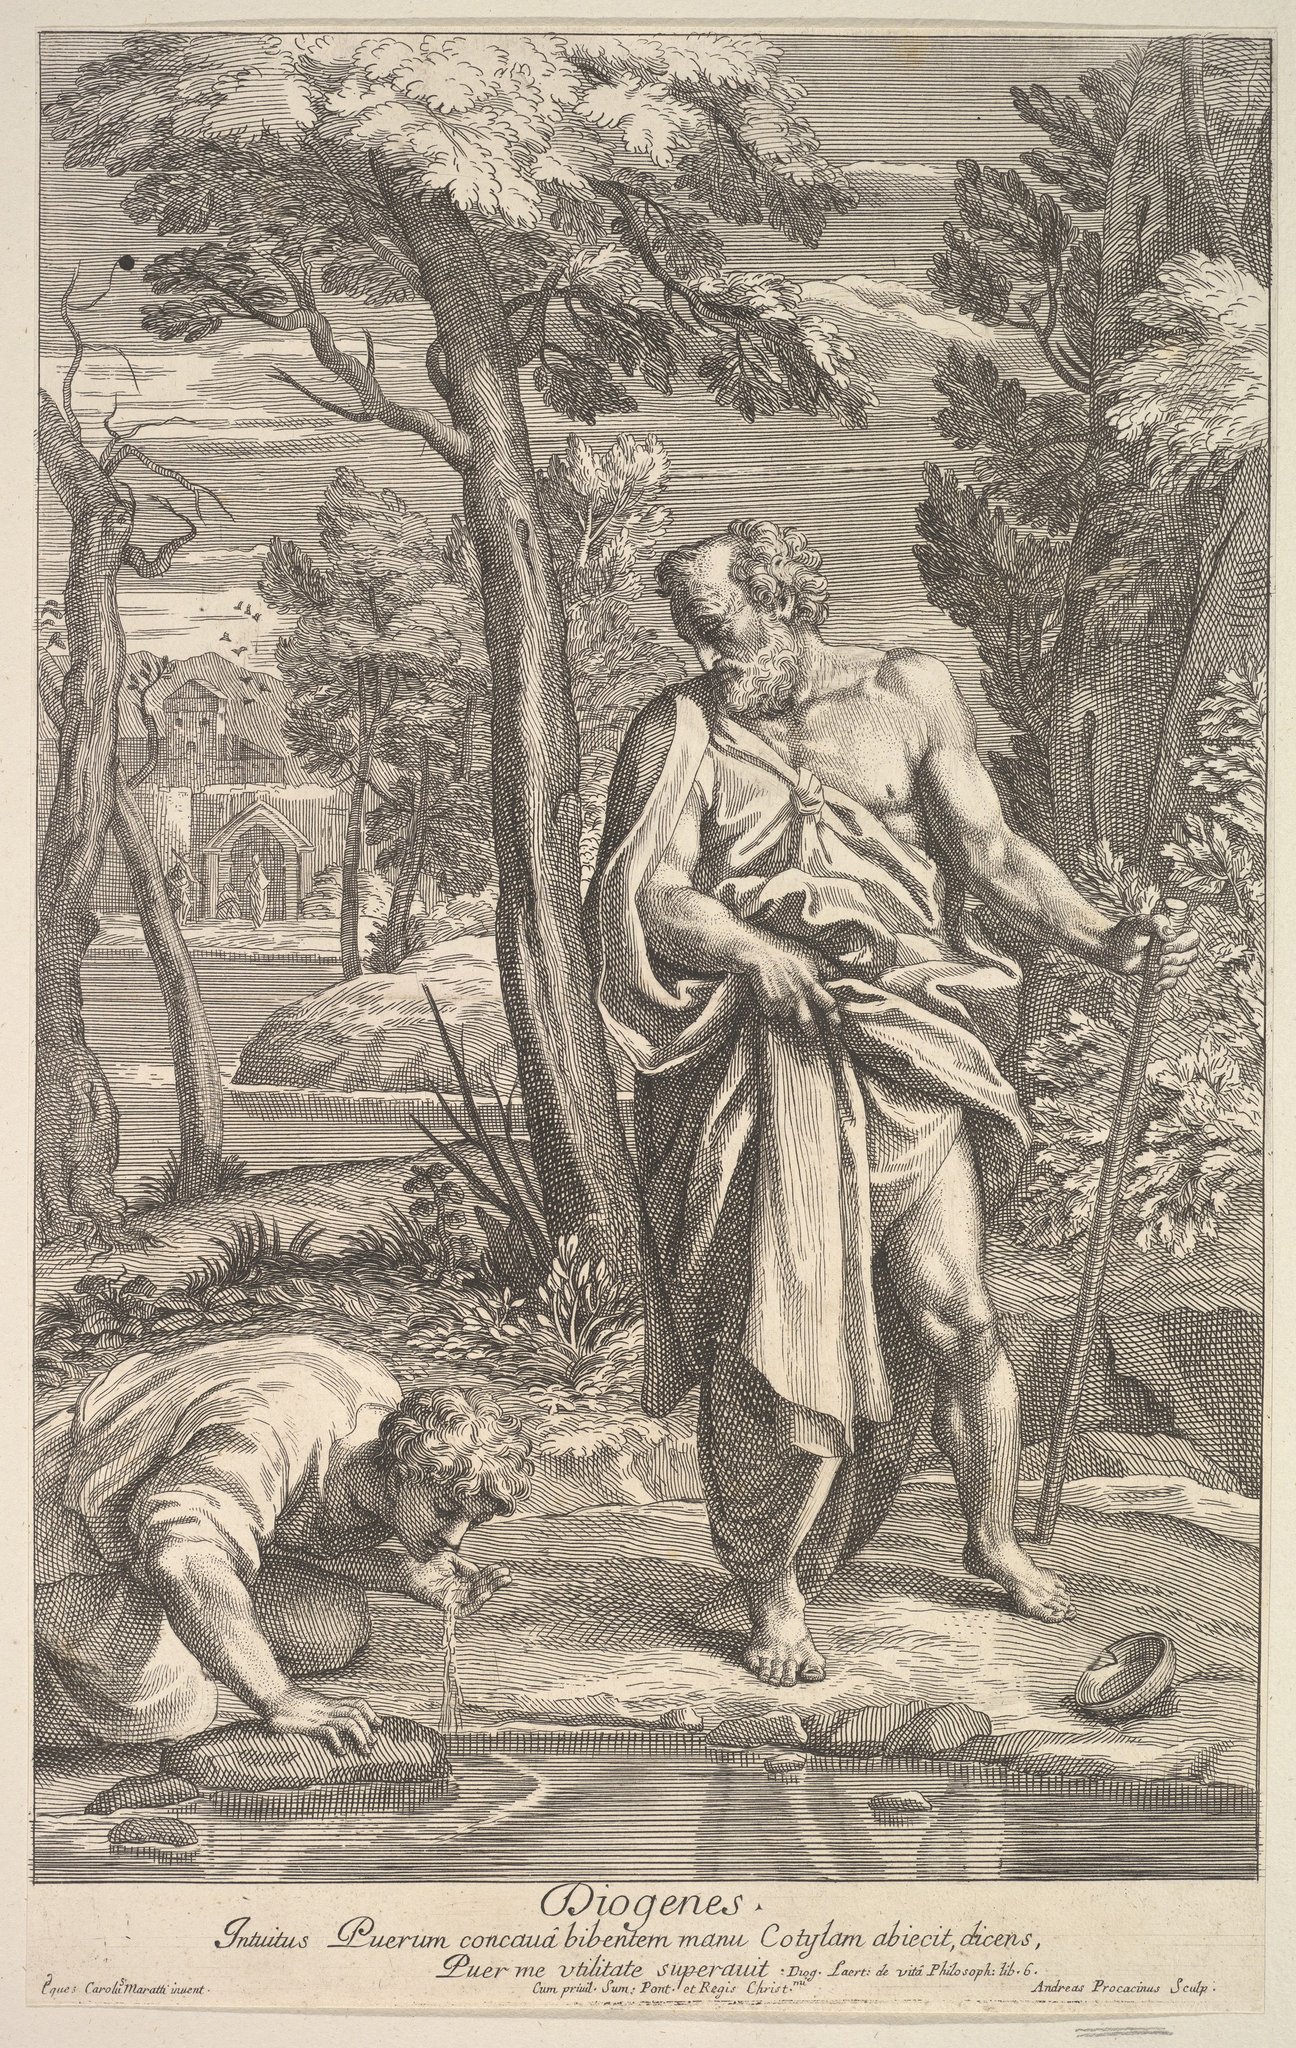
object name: print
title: Diogenes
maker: andrea procaccini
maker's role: artist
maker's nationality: italian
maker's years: 1671-1734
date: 1685-1734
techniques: etching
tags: diogenes,men